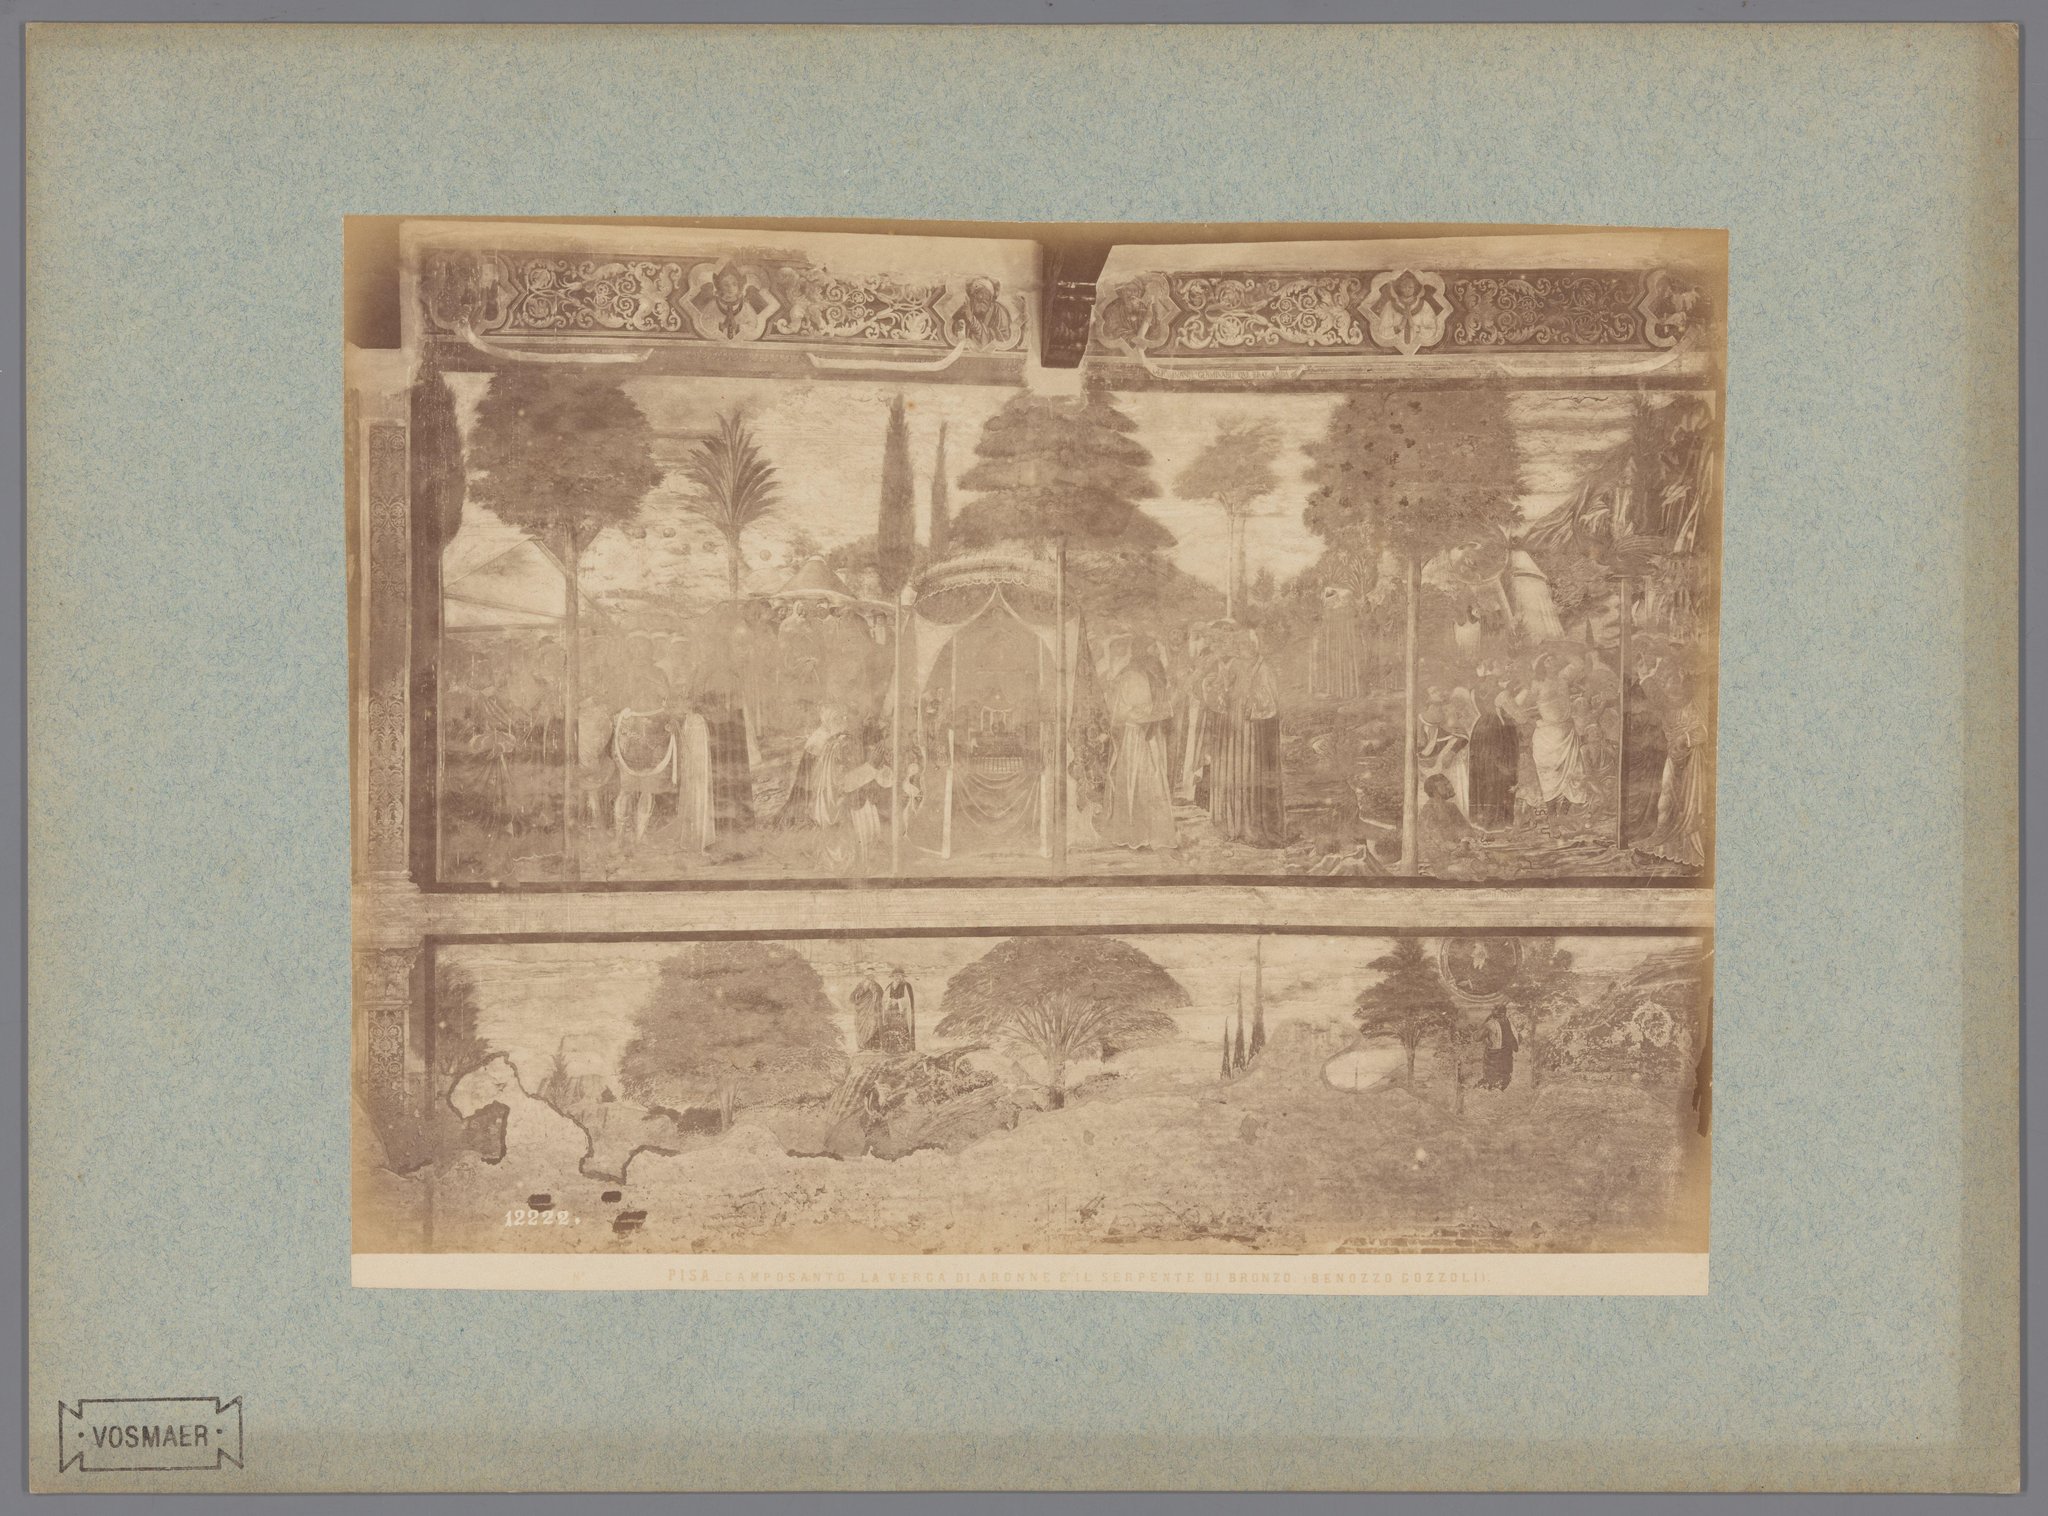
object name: reproduction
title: Fotoreproductie van het fresco De scepter van Aäron en de bronzen slang naar Benozzo Gozzoli in het Camposanto te Pisa, Italië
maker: benozzo gozzoli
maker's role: draughtsman, painter, sculptor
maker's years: 1421-1497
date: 1857-1900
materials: cardboard, paper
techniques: albumen print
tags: picture, painting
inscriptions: number: ‘12222.’, collector's mark: ‘VOSMAER’